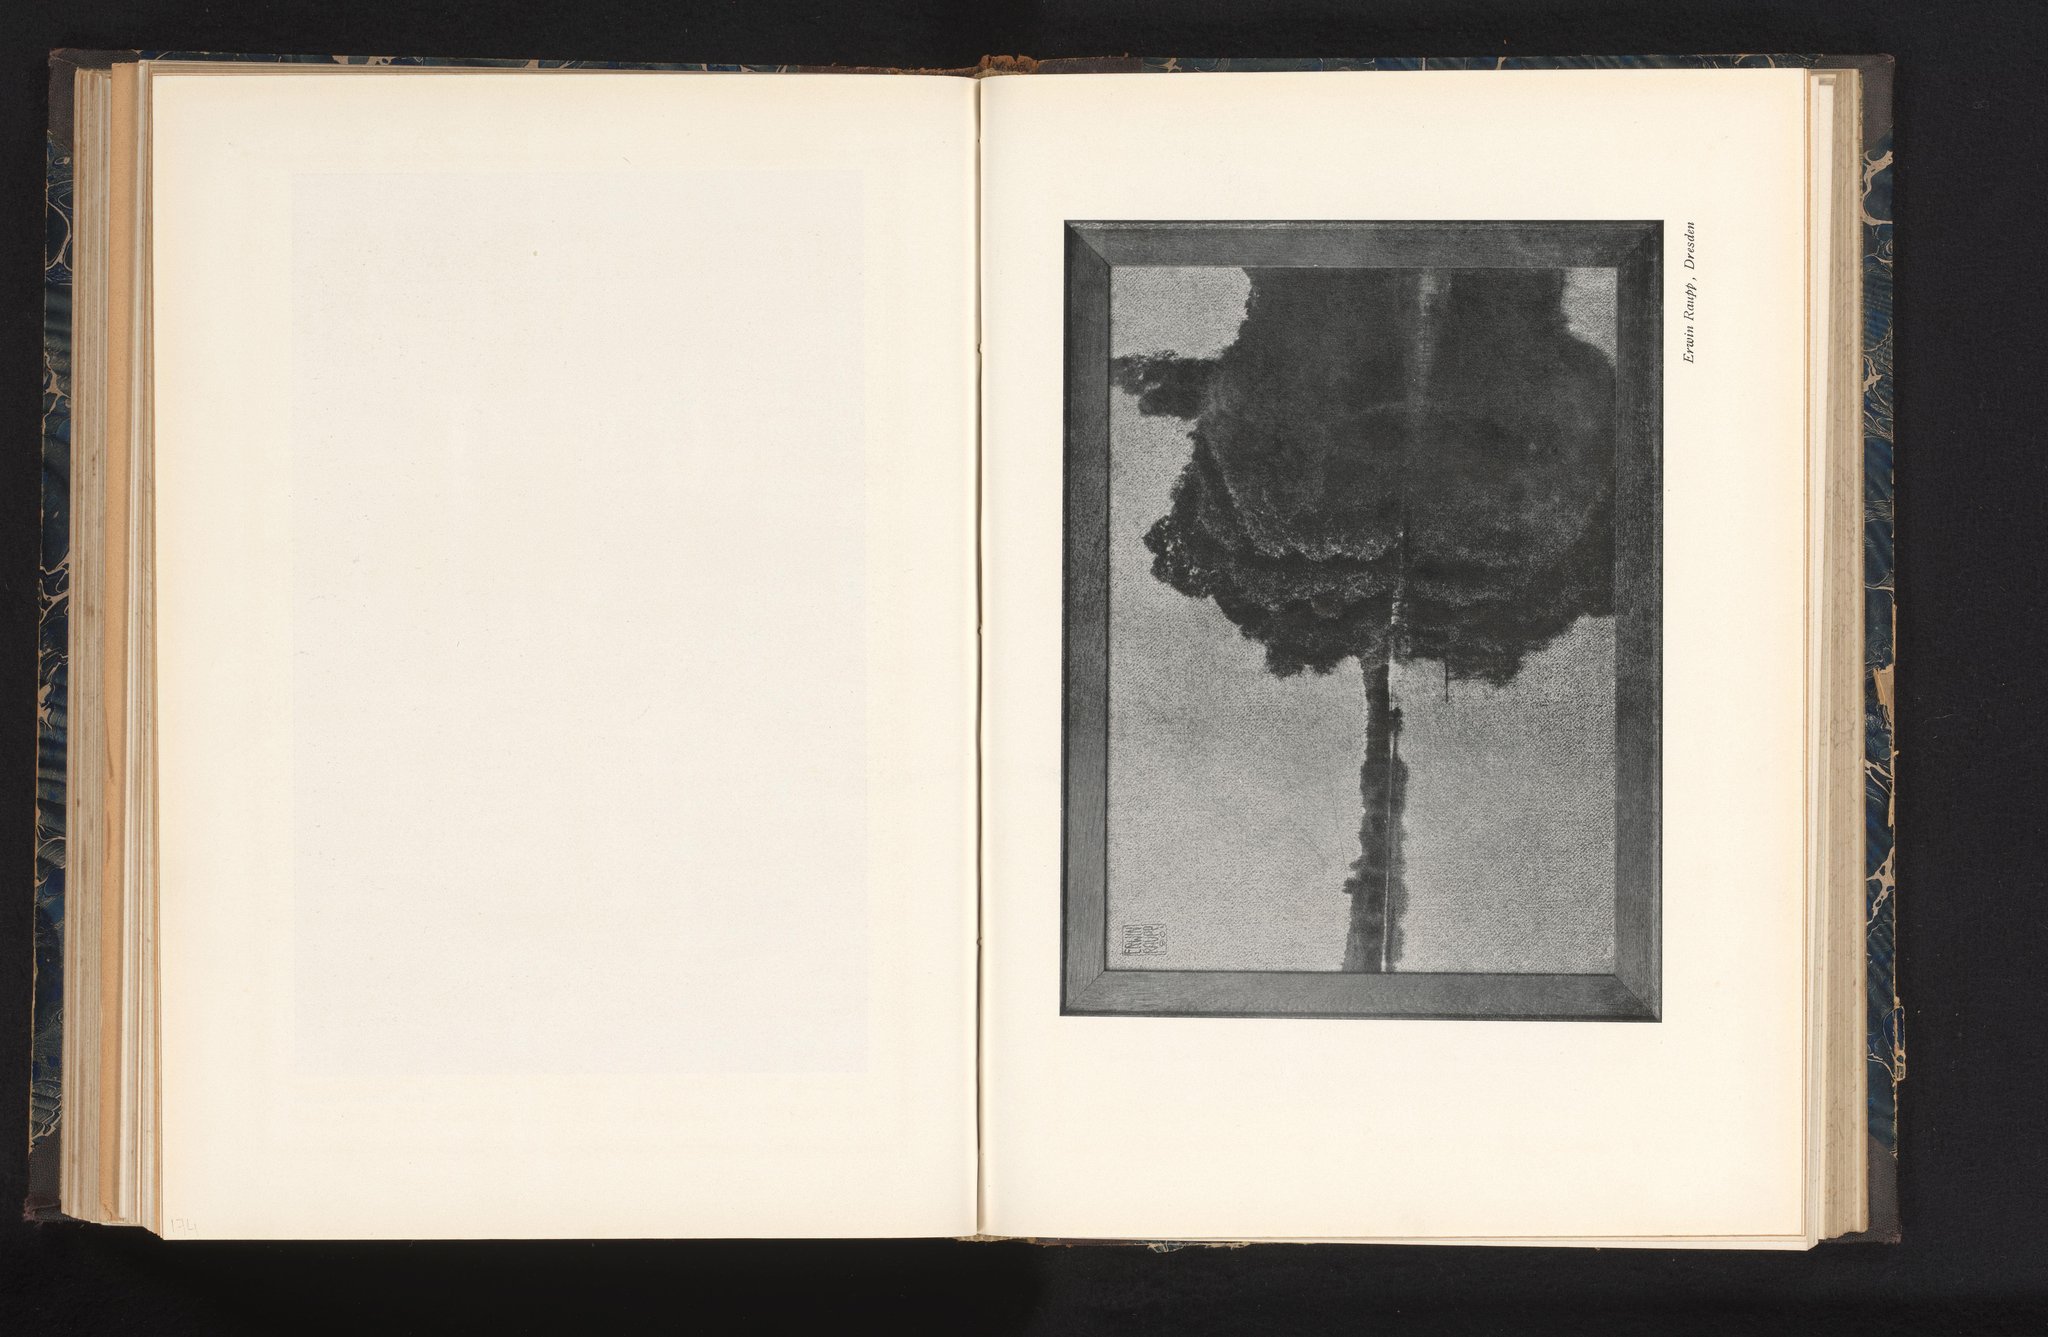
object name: page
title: Gezicht op een aantal bomen aan het water in een lijst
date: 1897-1902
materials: paper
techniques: autotype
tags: trees, landscapes with waters, waterscapes, seascapes (in the temperate zone), frame of painting, etc.